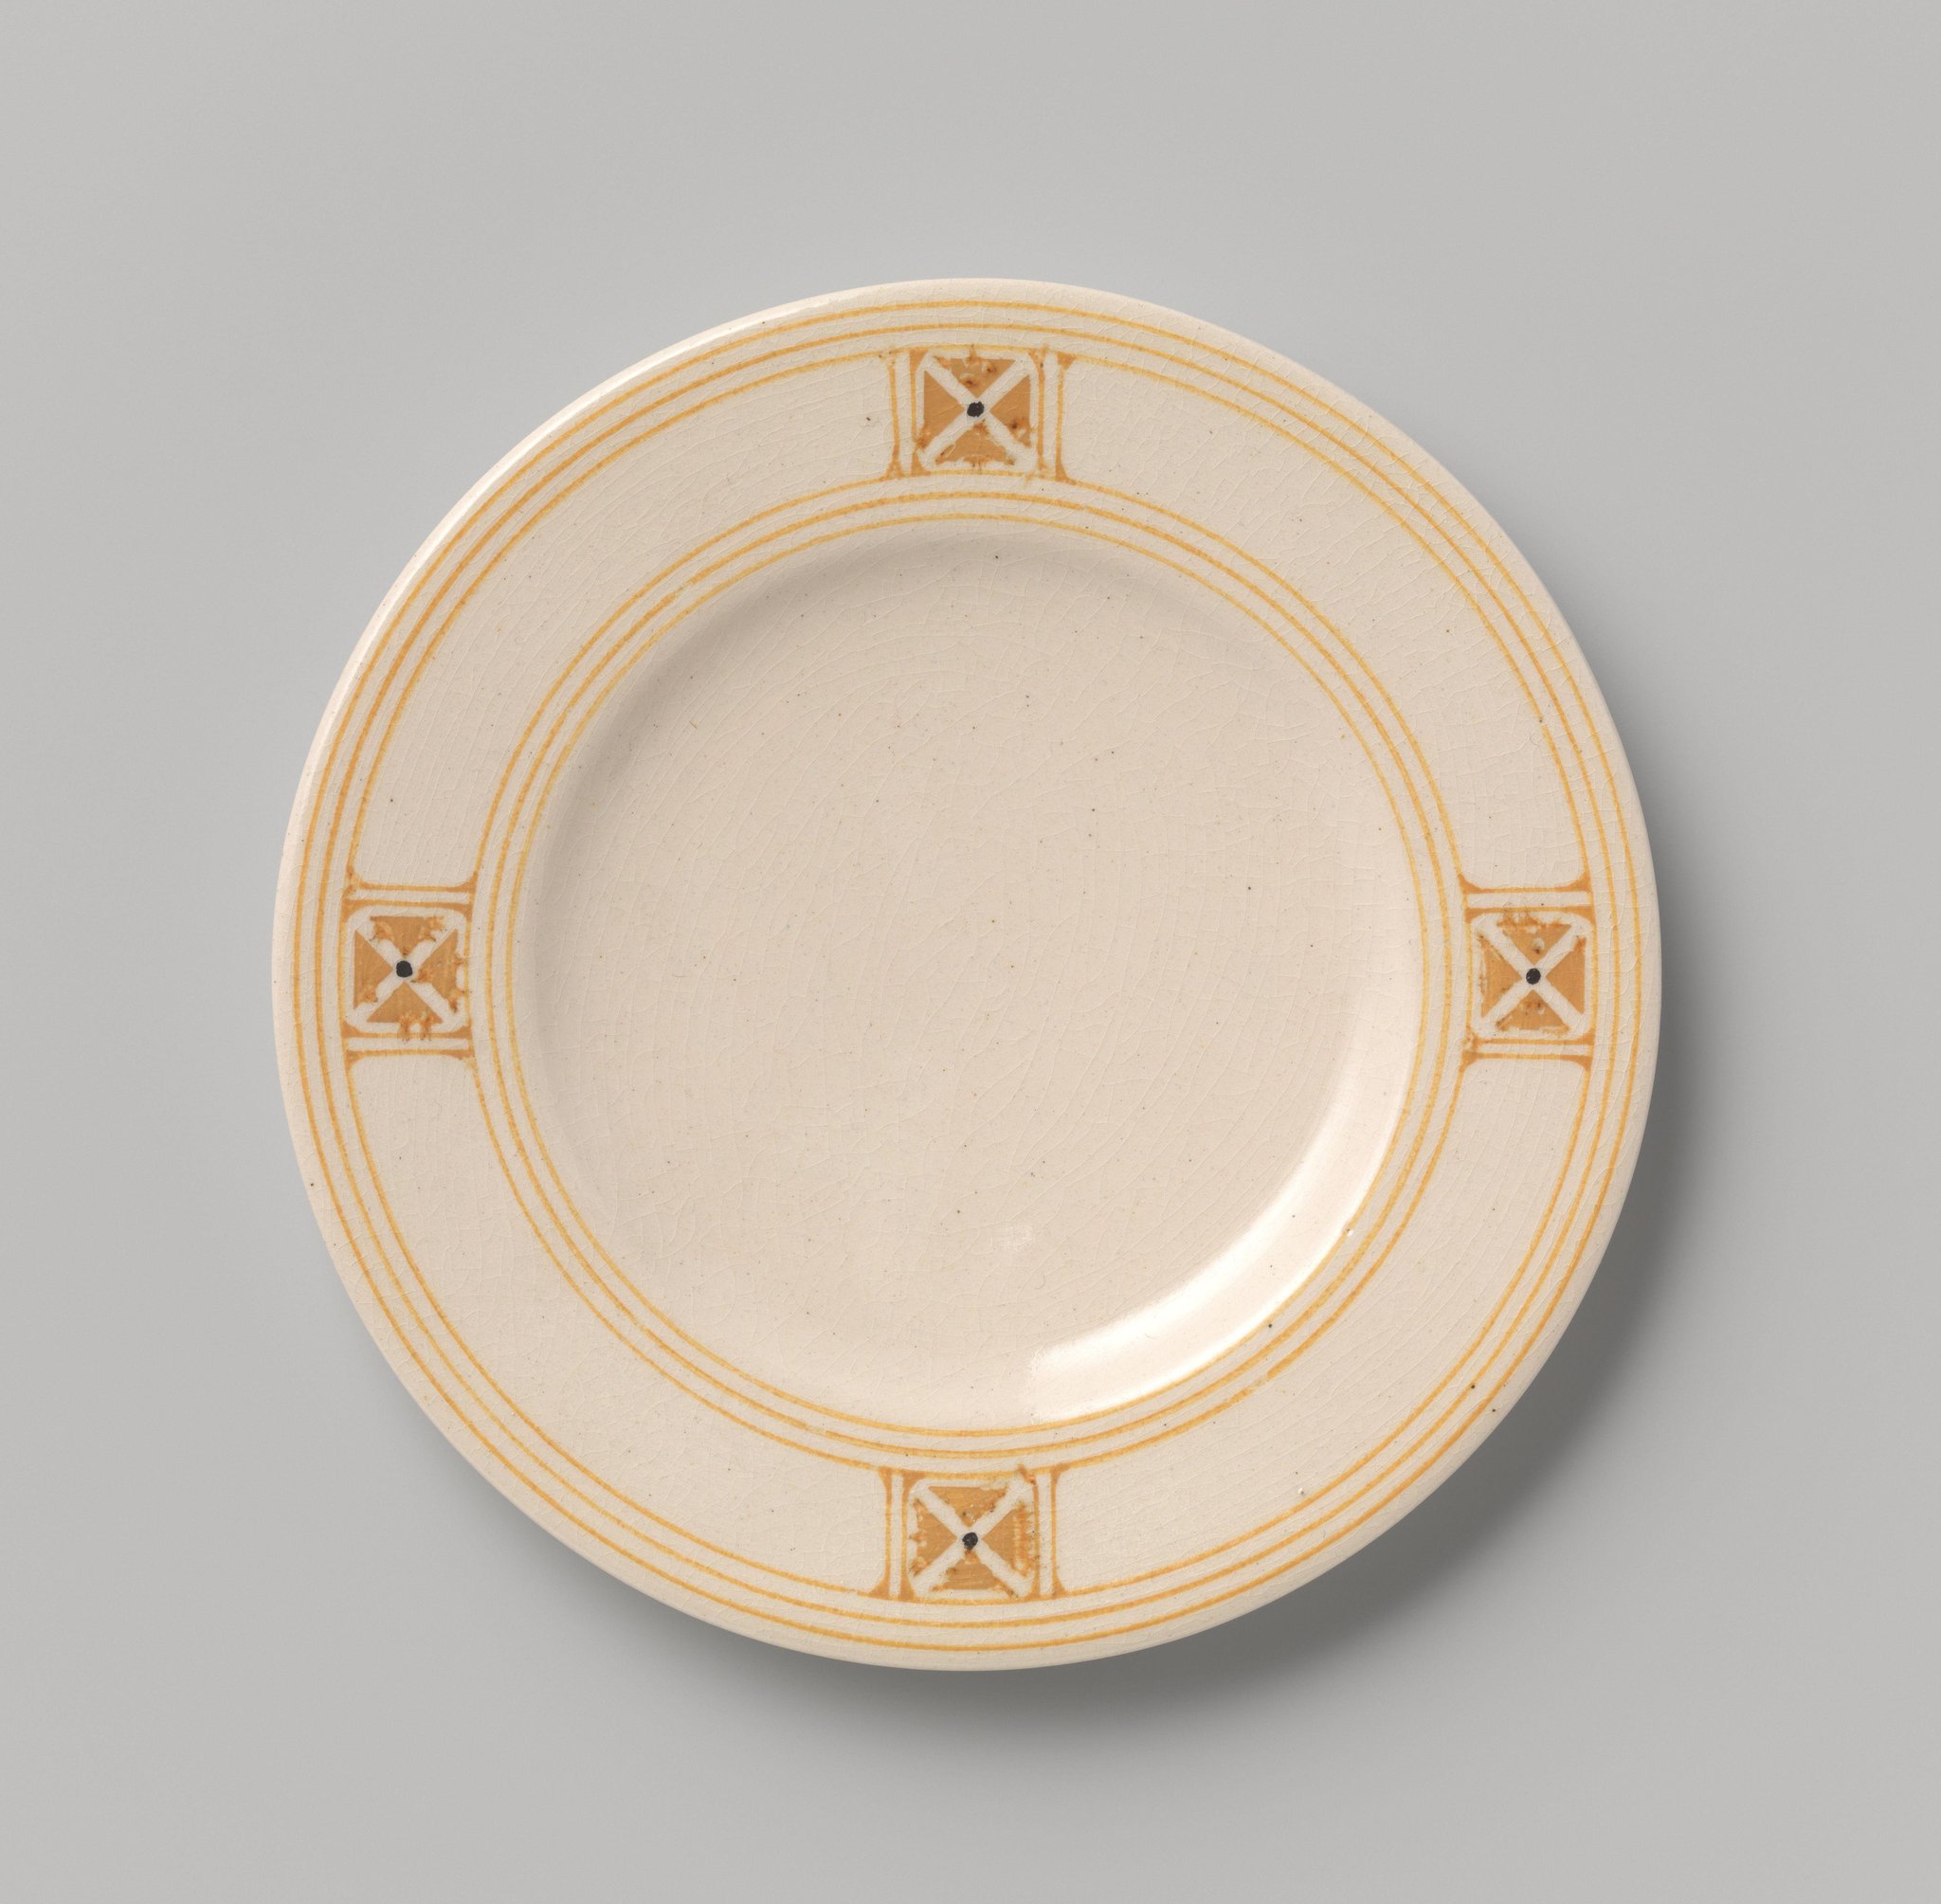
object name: platter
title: Gebakschotel versierd met blokmotief en stippen in geel en zwart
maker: chris van der hoef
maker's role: ceramicist, draughtsman, sculptor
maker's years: 1875-1933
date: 1900-1925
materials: earthenware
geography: oegstgeest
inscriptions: mark: ‘Amphora Holland ontw. C.J. v d Hoef 268A//horizontale streep 1 J.d V; ingekraste letter J’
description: Gebakschotel van aardewerk. De randen van de schotel zijn versierd met een blokmotief met stippen in geel en zwart tussen aan weerszijden drie gele biezen.